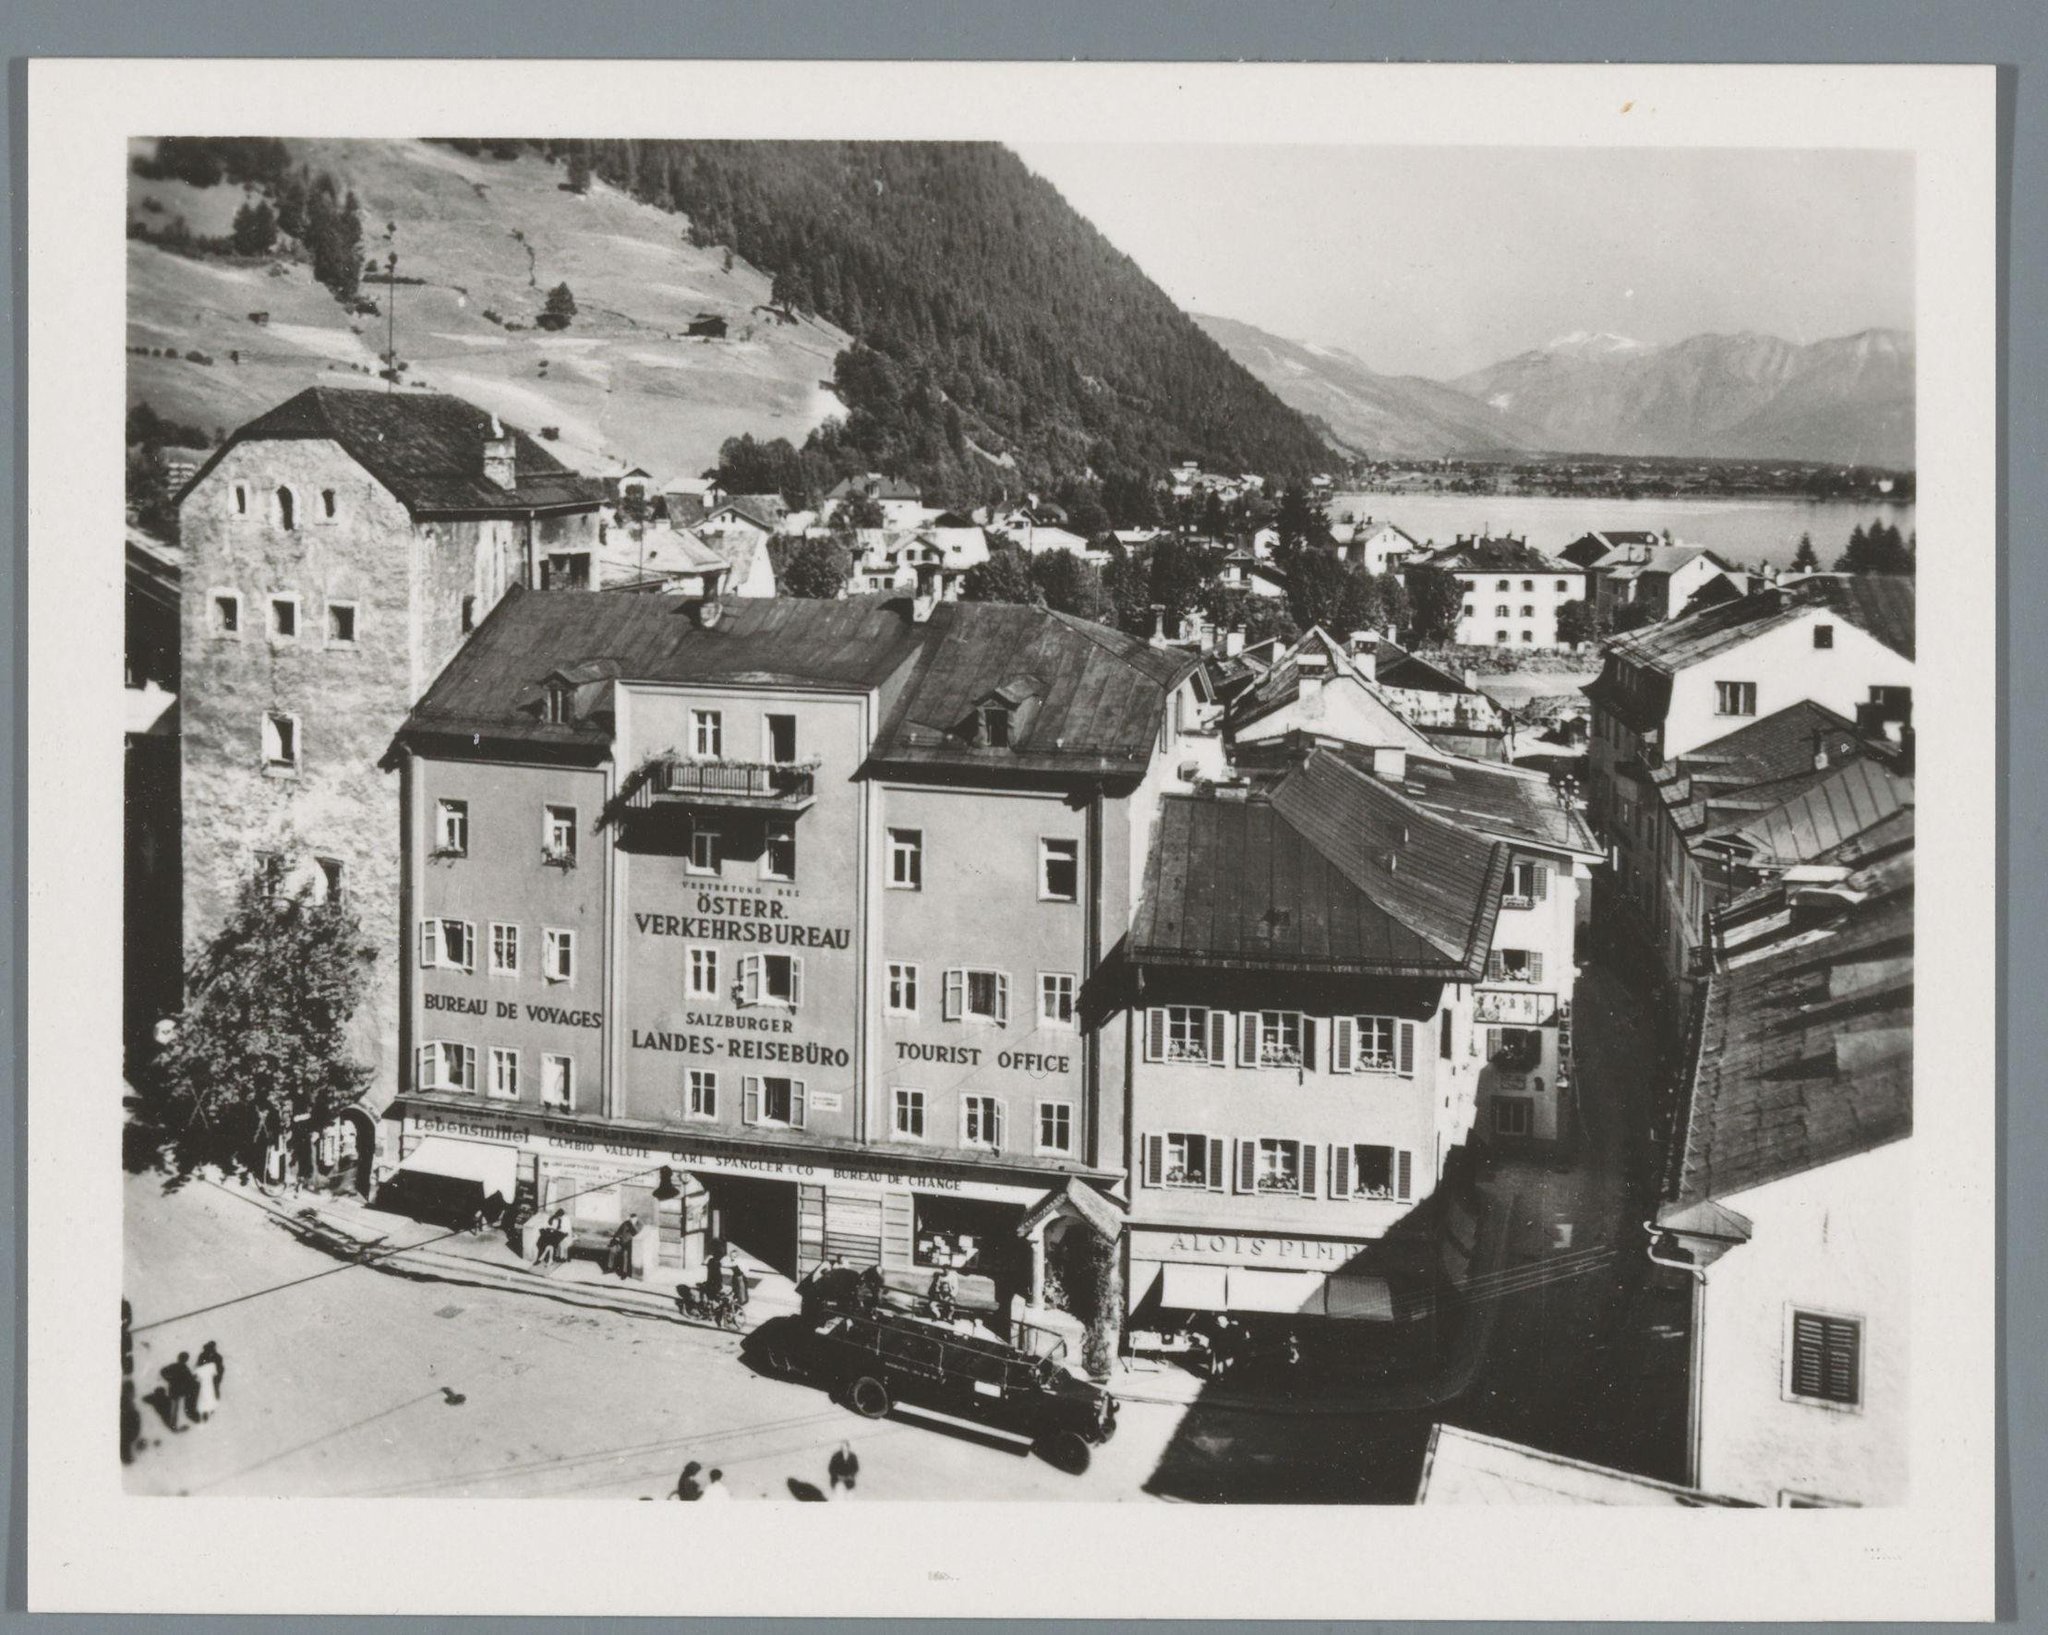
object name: photograph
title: Gezicht op een plein in Zell am See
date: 1950-1960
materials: photographic support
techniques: gelatin silver print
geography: zell am see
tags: square, place, circus, etc., advertising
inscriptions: inscription: ‘Zell am See, Stadtplatz’, number: ‘25293’